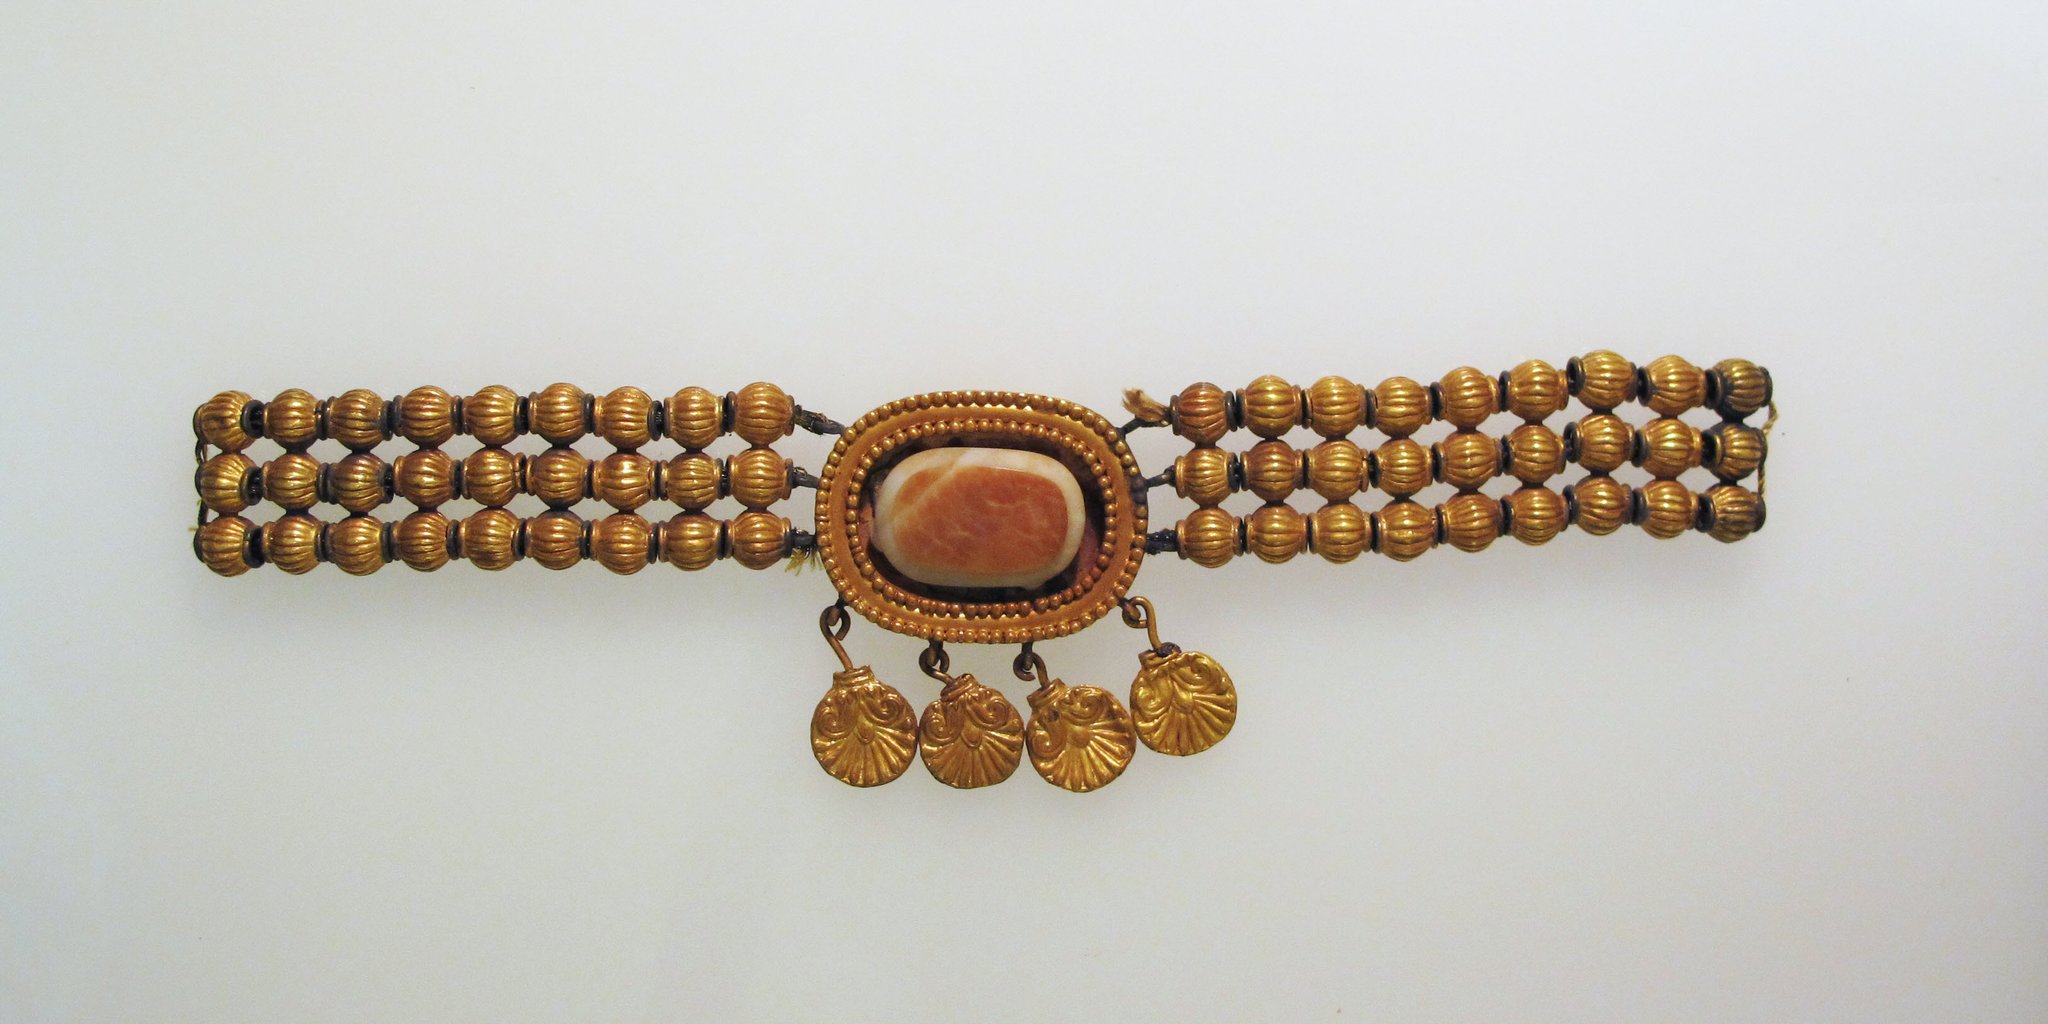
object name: necklace with palmette pendant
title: Necklace with gold beads and pendants attached to agate in box setting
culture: greek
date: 500-301 BCE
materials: gold